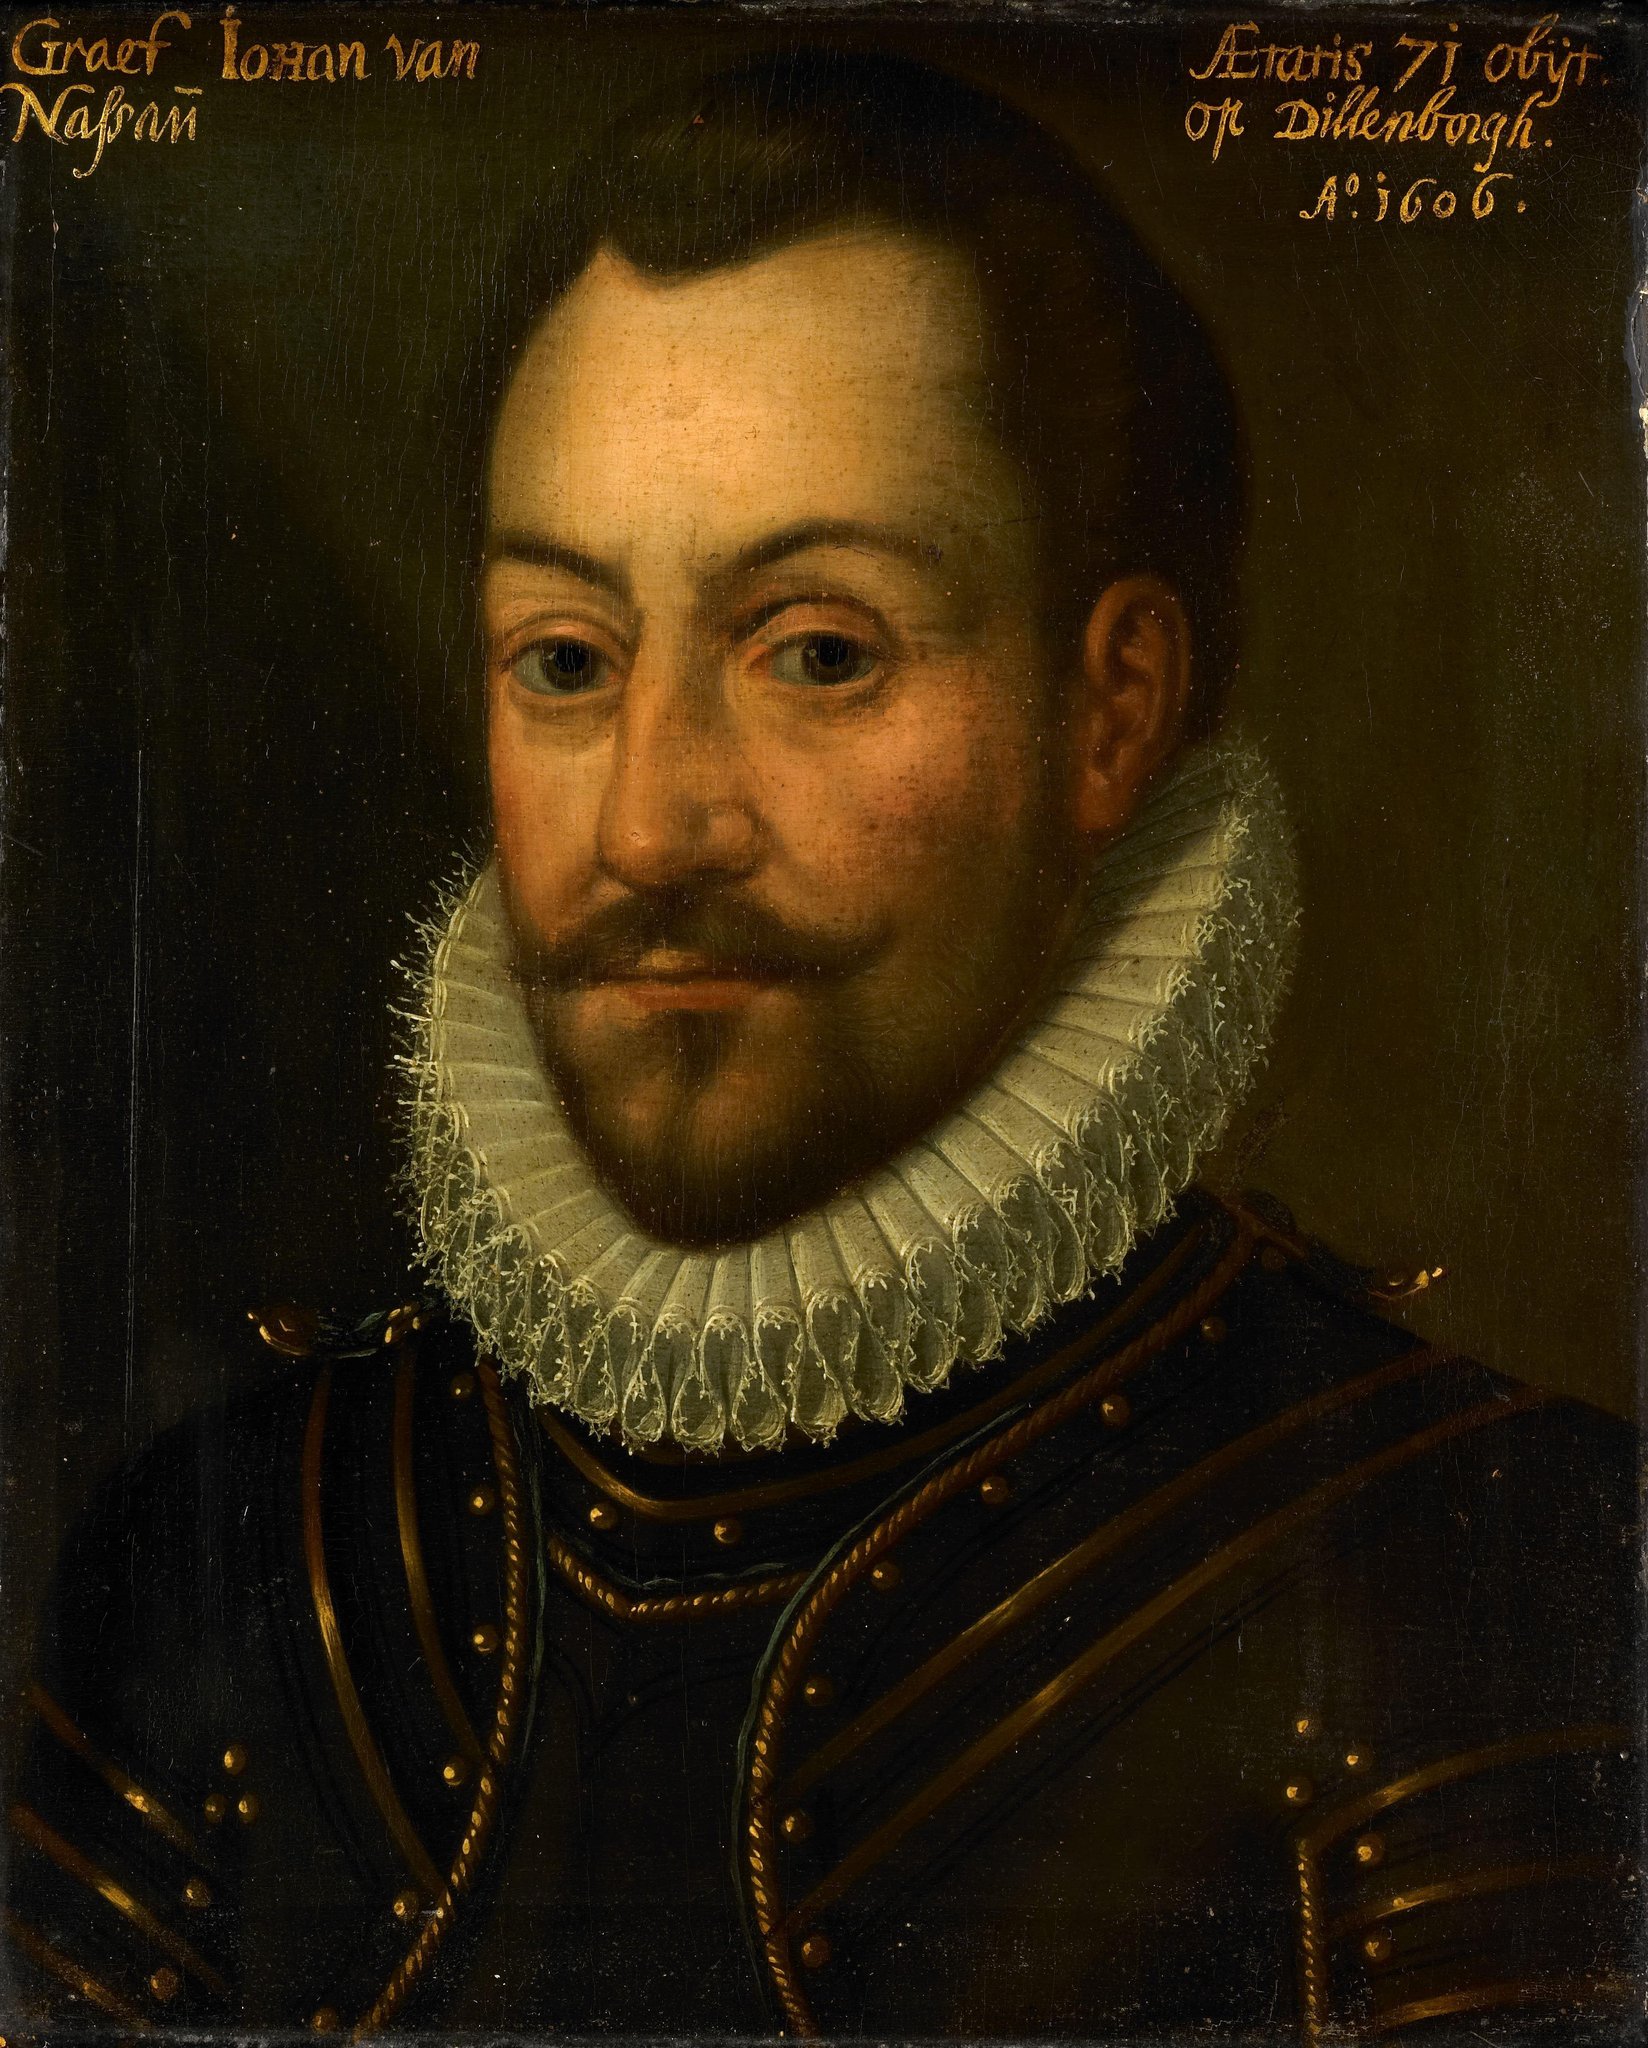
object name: painting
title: Portrait of an Unknown Count or Officer, possibly Jan the Elder (1535-1606), Count of Nassau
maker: Anonymous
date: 1609-1633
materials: oil, panel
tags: historical persons, historical persons not known by name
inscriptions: inscription, top left: ‘Graef IoHan van / Nassau’, inscription, top right: ‘Ætatis 71 obijt. / op Dillenborgh. / Aº. 1606’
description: Portret van een onbekende graaf of officier, vermoedelijk Jan de Oude (1535-1606), graaf van Nassau. Buste in wapenrusting naar links. Onderdeel van de reeks portretten afkomstig uit het Stadhouderlijk Hof te Leeuwarden.